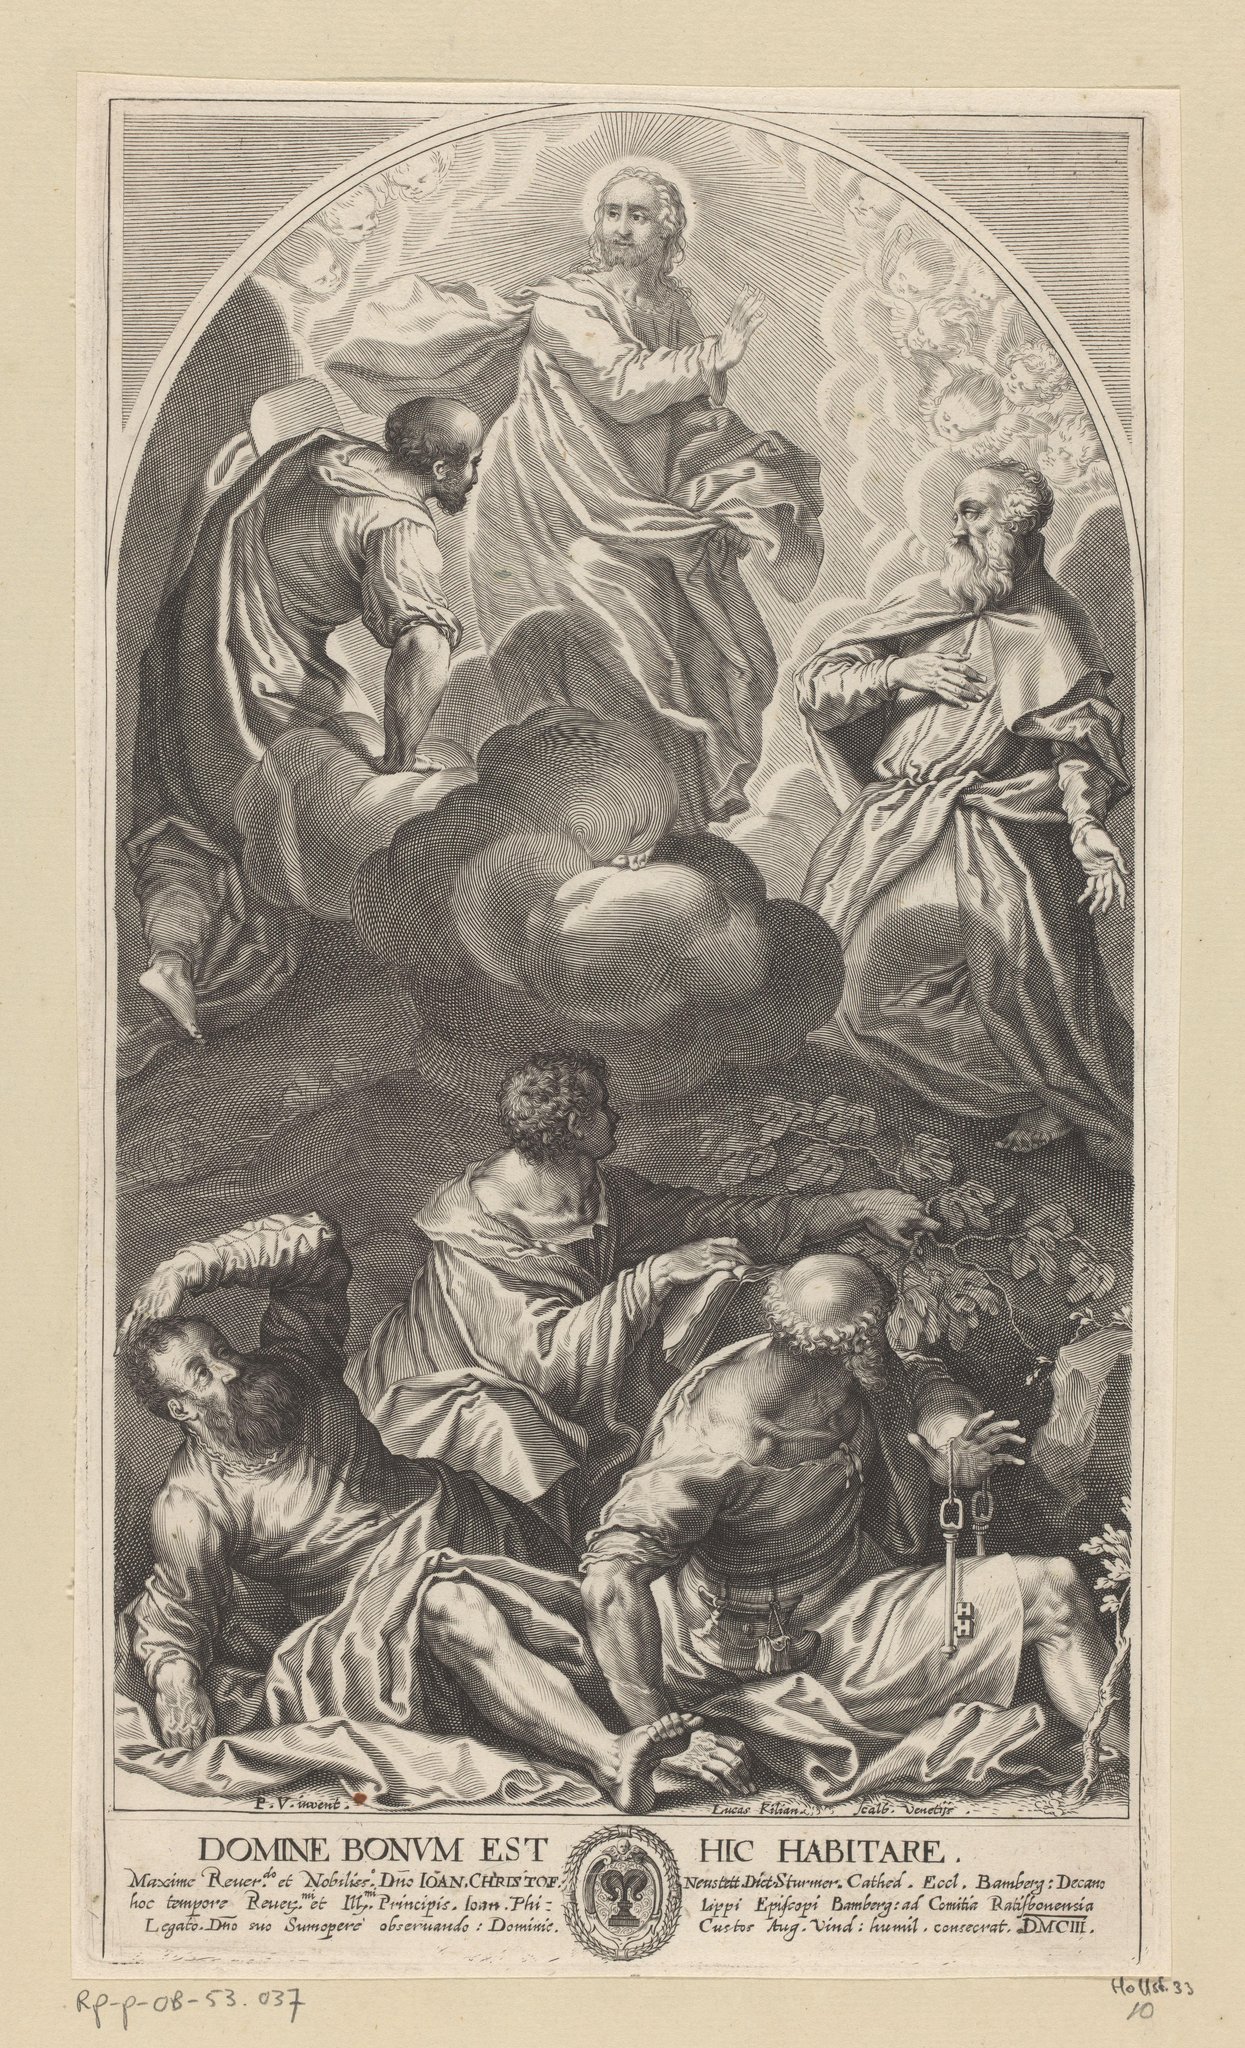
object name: print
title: Transfiguratie van Christus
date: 1589-1615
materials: paper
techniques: engraving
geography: augsburg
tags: christ, peter, james and john climb the mountain ~ the transfiguration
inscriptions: collector's mark: Lugt 240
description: Het schilderij door Paolo Veronese uit ca. 1555 waarop deze prent is gebaseerd bevindt zich in de kathedraal Santa Maria Assunta te Montagnana.